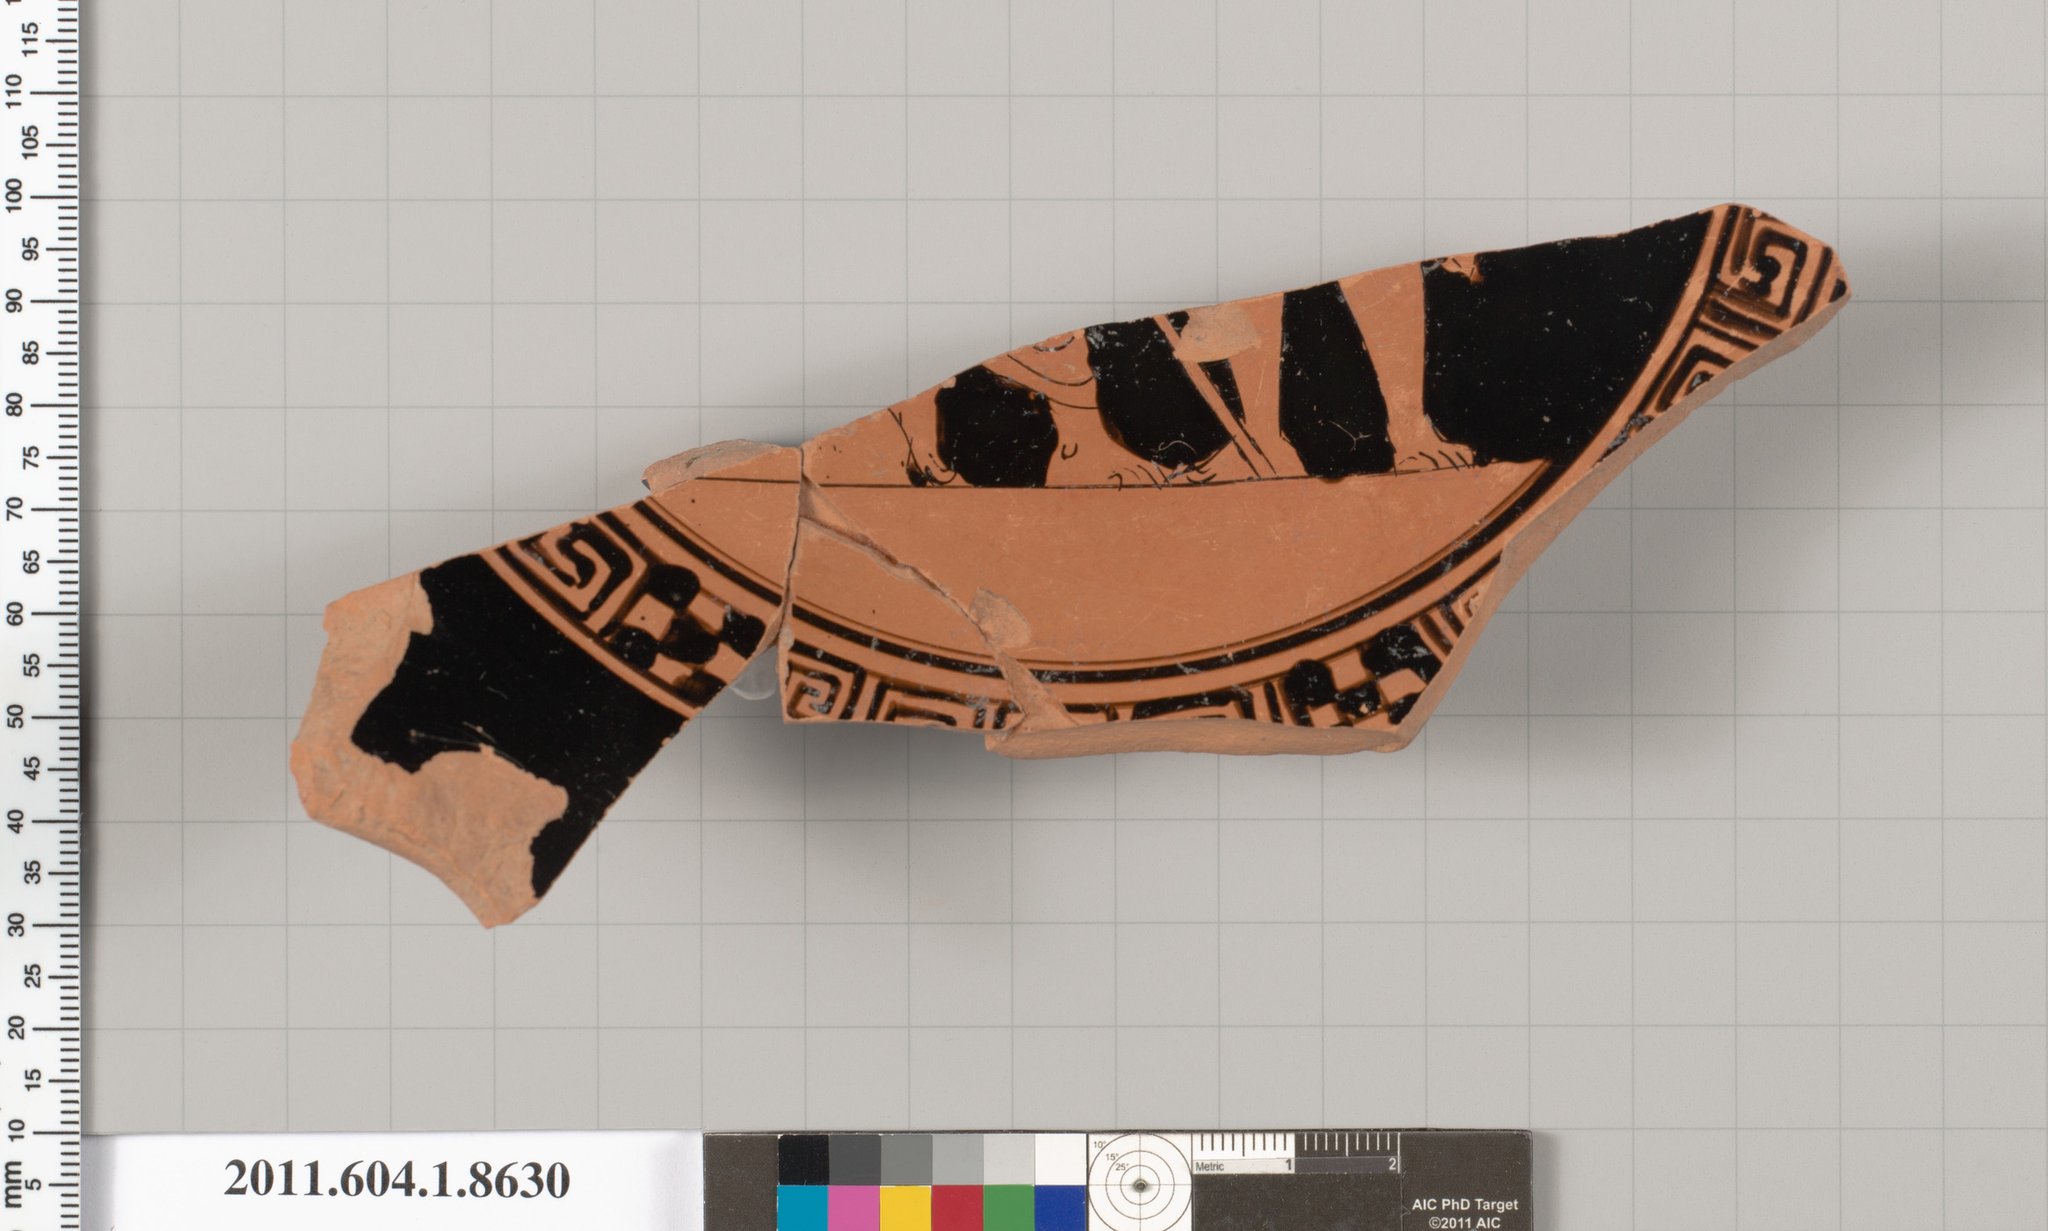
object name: kylix fragment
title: Terracotta fragment of a stemless kylix (drinking cup)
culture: greek, attic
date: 460-450 BCE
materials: terracotta